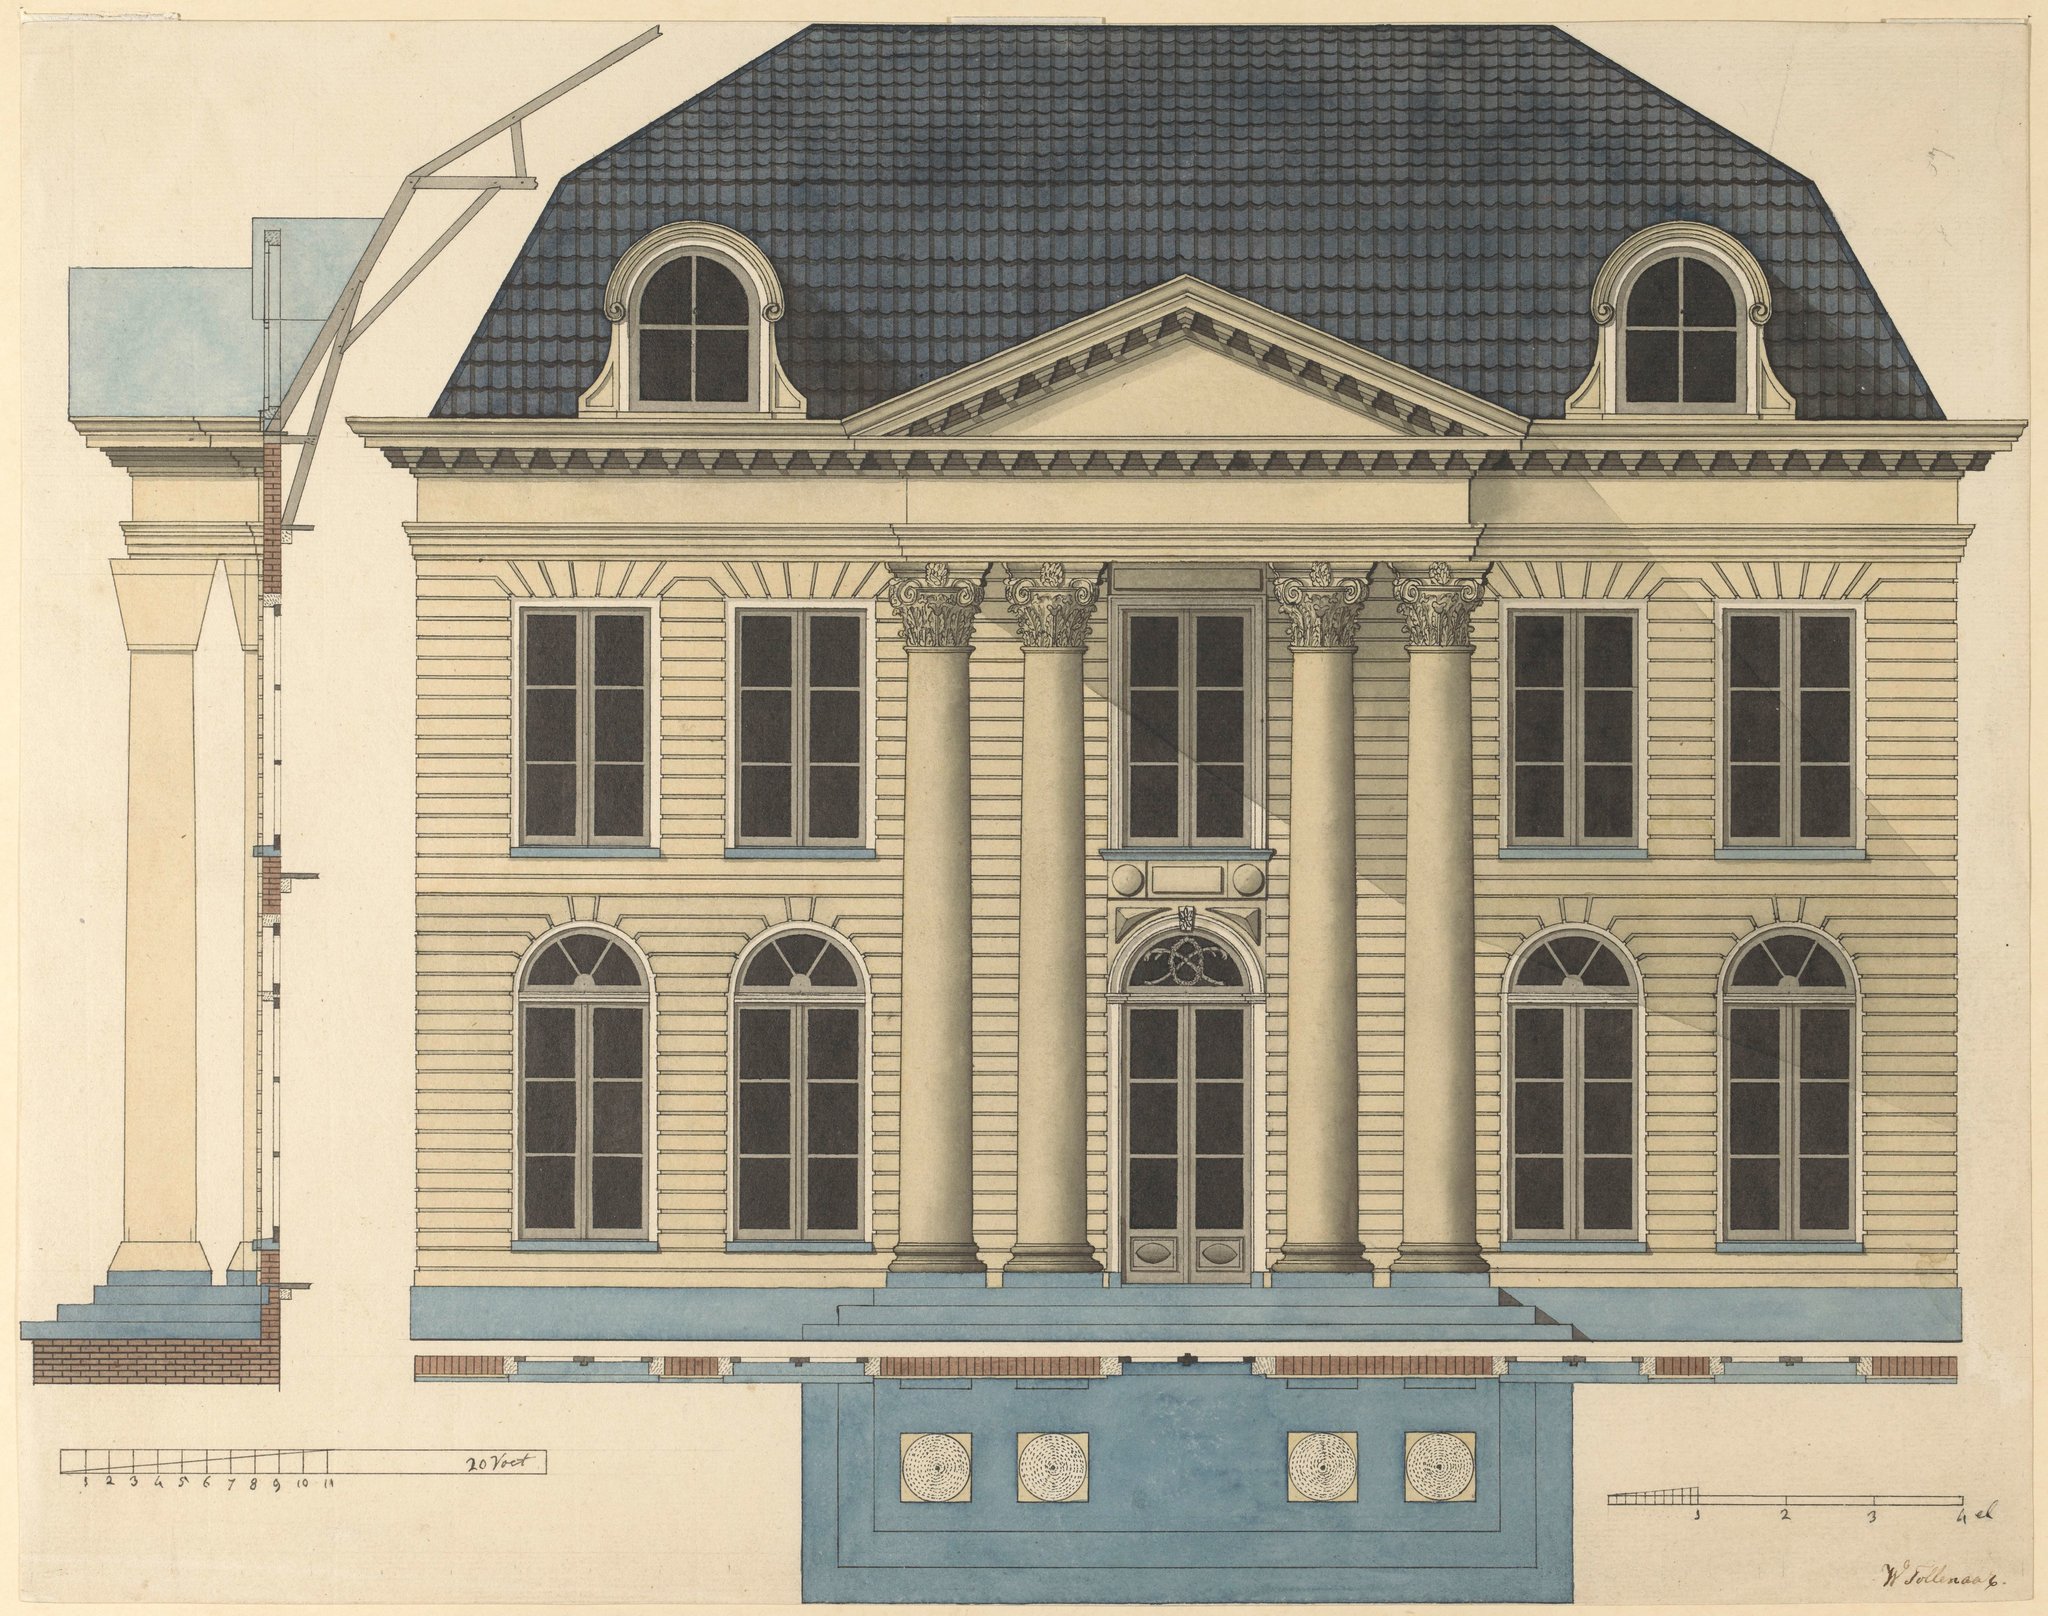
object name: drawing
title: Voorgevel van Hofstede Sparenhout bij Haarlem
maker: wybrand tollenaar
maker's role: draughtsman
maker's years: 1778-1852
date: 1788-1852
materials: ink, paper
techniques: brush, pen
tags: country-house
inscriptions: collector's mark: Lugt 2228, signature: ‘W. Tollenaar.’, annotation: ‘20 voet/ 4 el’